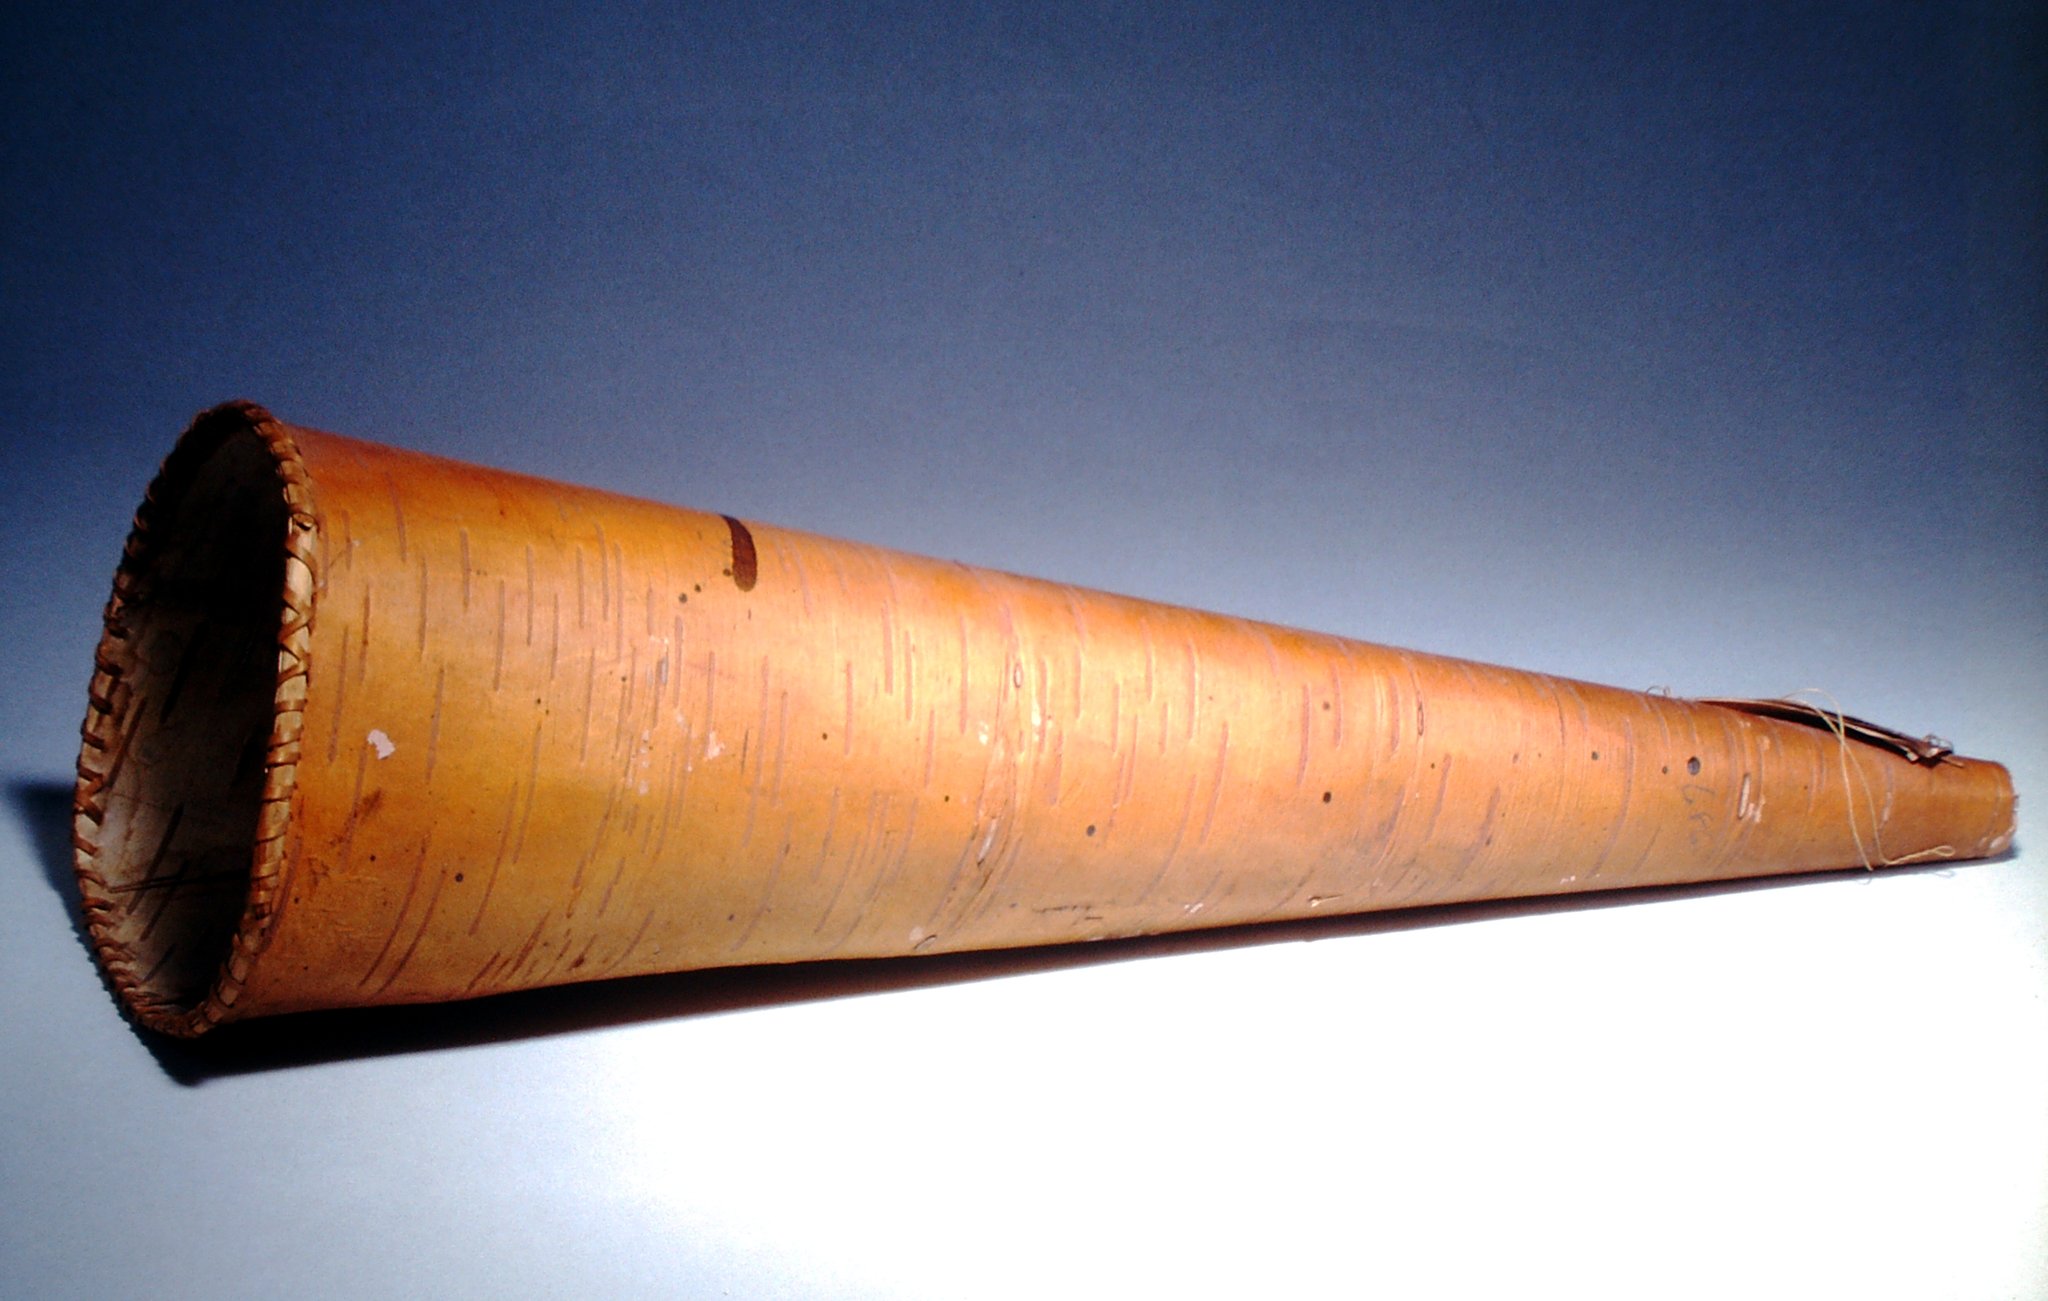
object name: bark trumpet moose call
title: Bark Trumpet / Moose Call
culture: native american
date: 1801-1900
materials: wood, cord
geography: canada